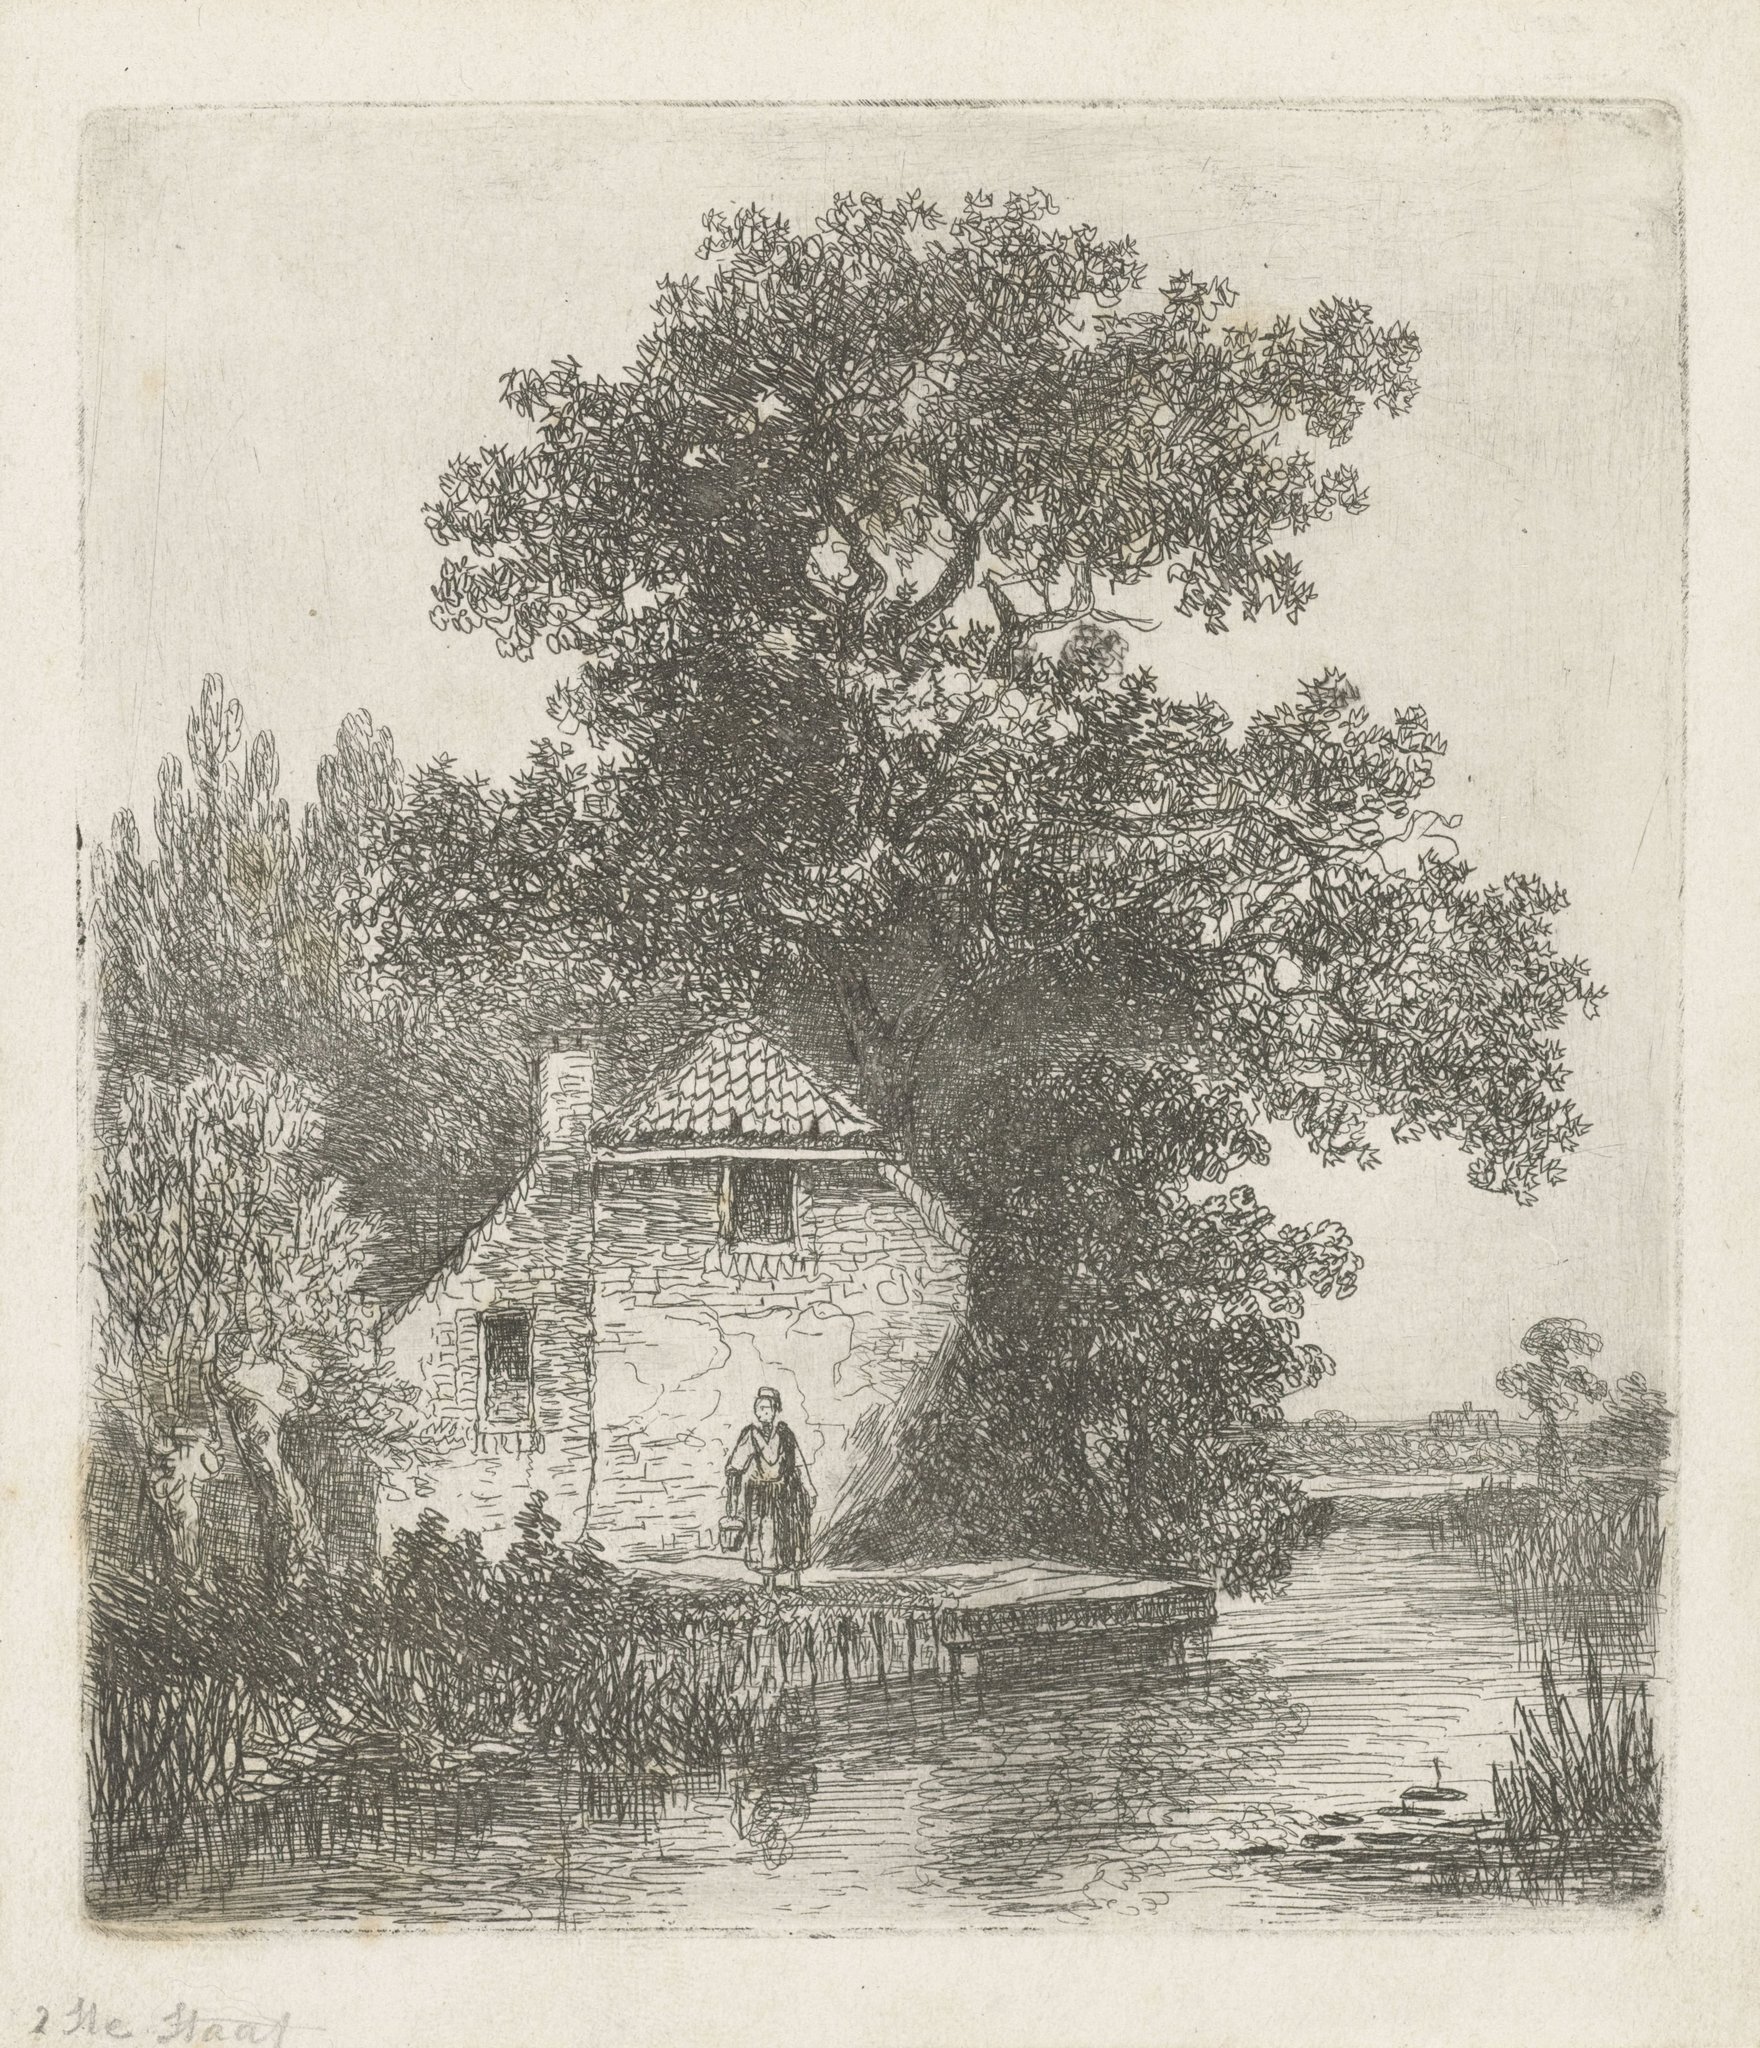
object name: print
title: Vrouw voor een boerderij aan het water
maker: hermanus jan hendrik van rijkelijkhuysen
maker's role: painter, print maker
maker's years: 1813-1883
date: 1823-1883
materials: paper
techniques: drypoint, etching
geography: utrecht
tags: containers, river, farm or solitary house in landscape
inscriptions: collector's mark: Lugt 1485, collector's mark: Lugt 2228